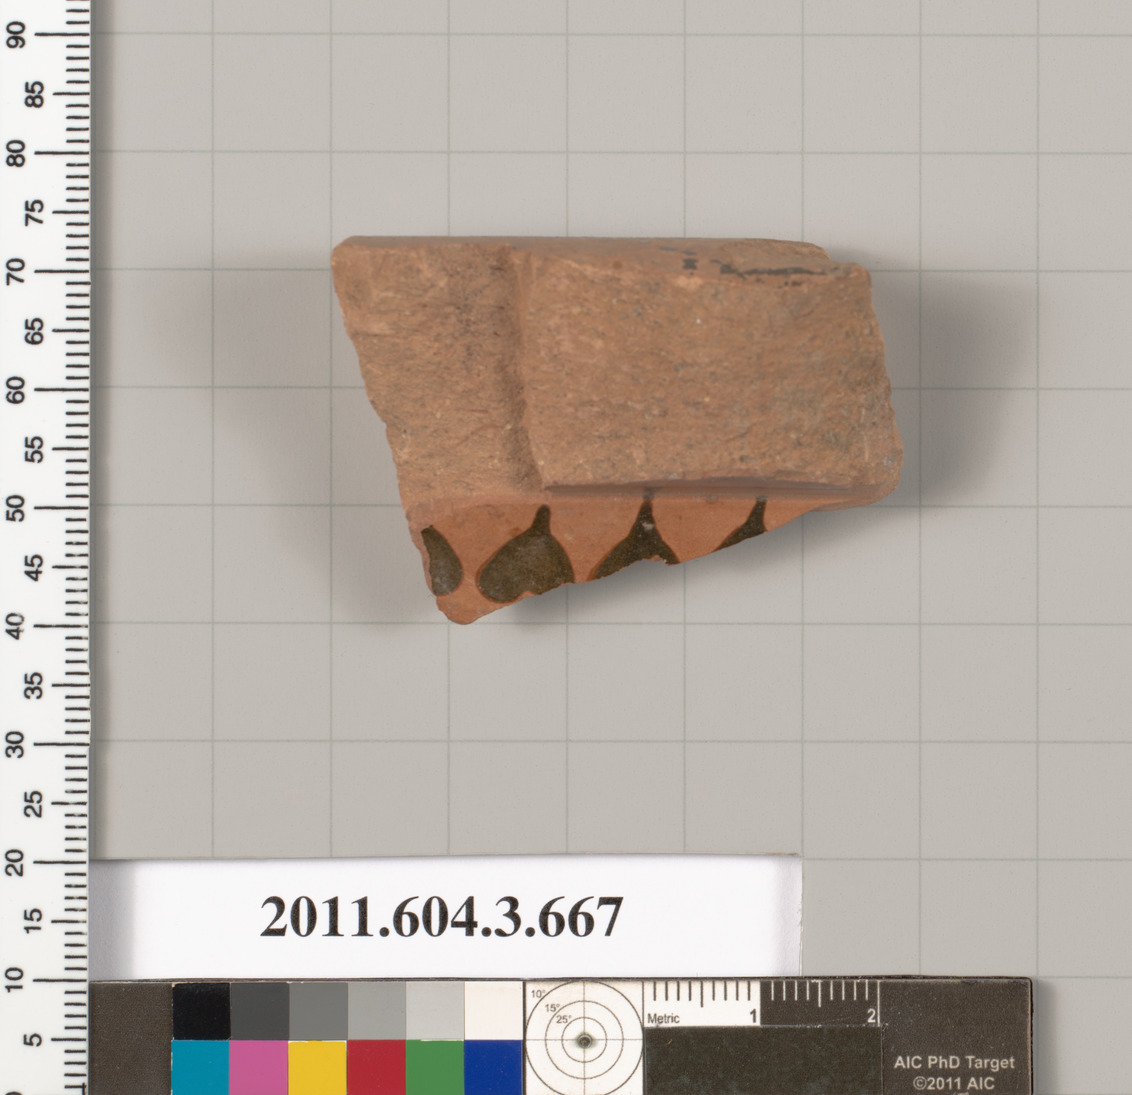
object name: calyx krater fragment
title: Terracotta fragment of a calyx-krater (bowl for mixing wine and water)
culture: greek, attic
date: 550-501 BCE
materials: terracotta